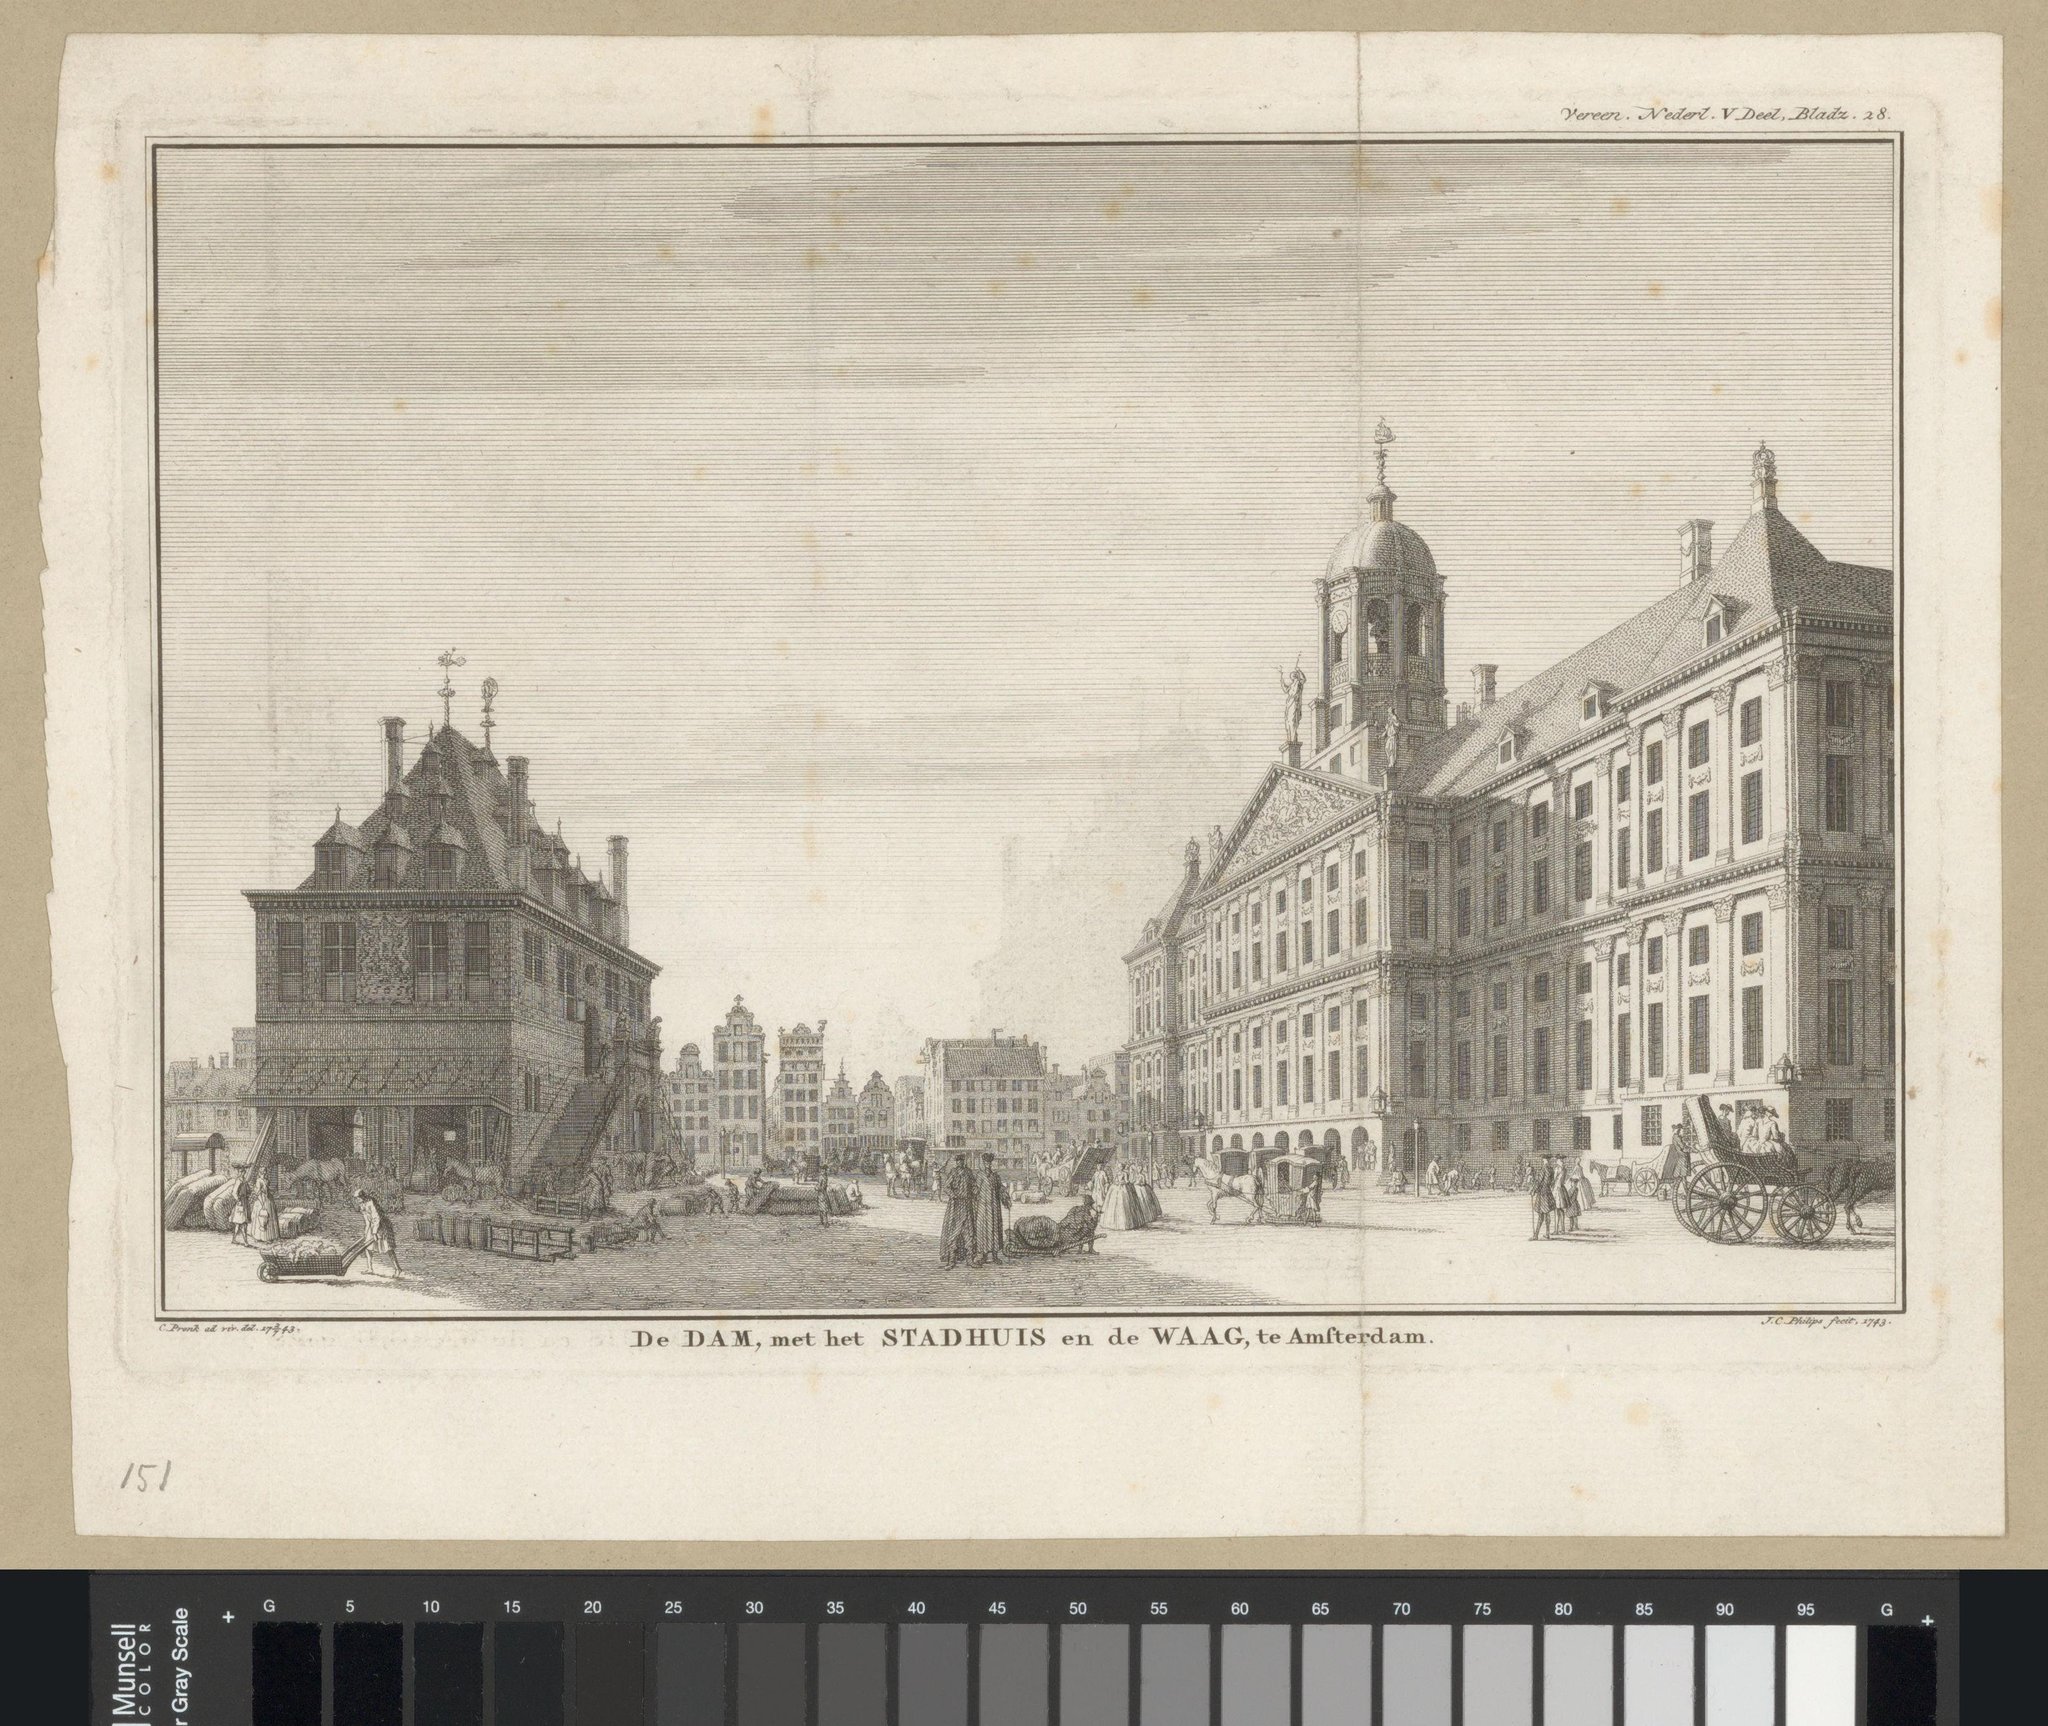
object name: print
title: Gezicht op het Stadhuis en de Waag op de Dam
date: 1744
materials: paper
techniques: engraving, etching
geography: amsterdam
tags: square, place, circus, etc., city-view in general; 'veduta', townhall, weigh-house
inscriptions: collector's mark: ‘7’ Lugt 1641b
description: Prent waarschijnlijk uit: Wagenaar, Jan. Tegenwoordige staat der Vereenigde Nederlanden, vyfde deel. Behelzende het vervolg der beschrijvinge van Holland. Met naauwkeurige plans der steden en printverbeeldingen versierd / Hedendaagsche historie, of tegenwoordige staat van alle volkeren; XVde deel (…). Amsterdam: Isaak Tirion, 1744.